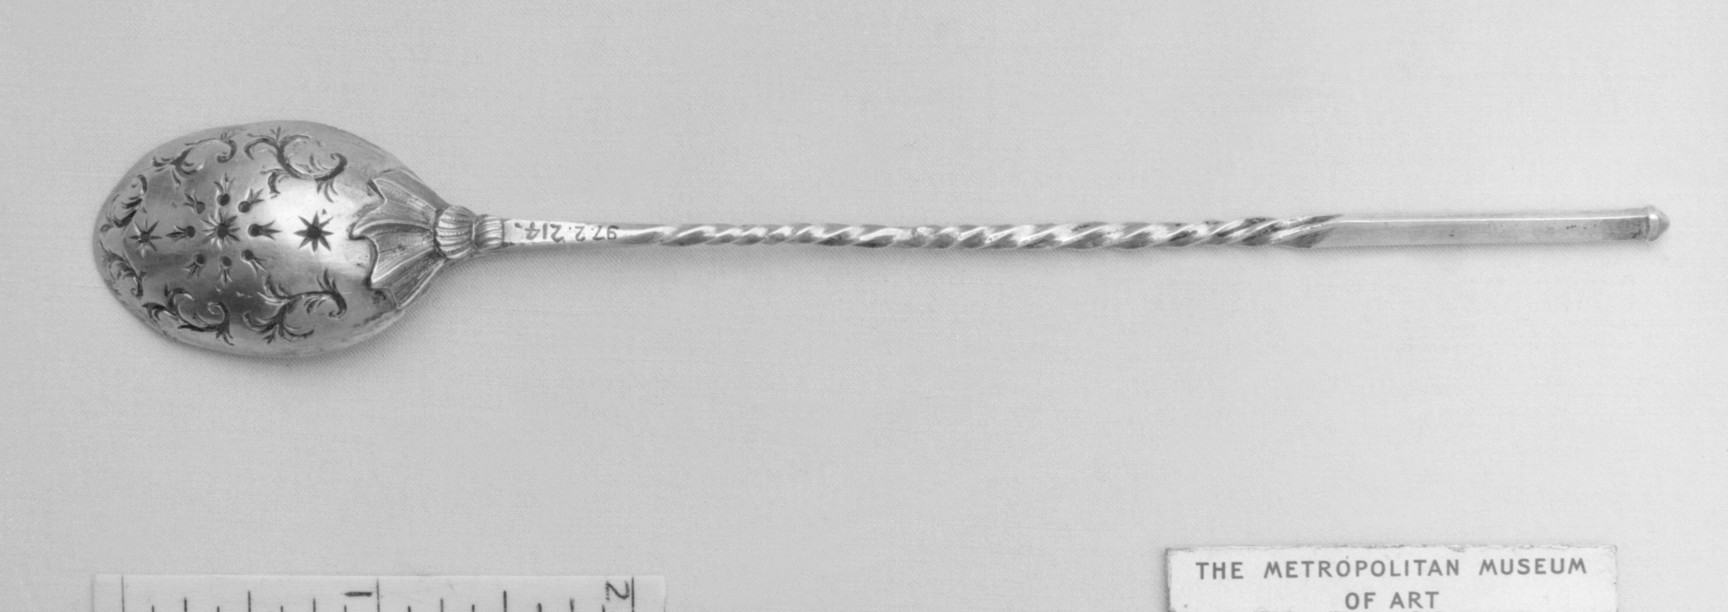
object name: skimmer spoon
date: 1701-1800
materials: silver